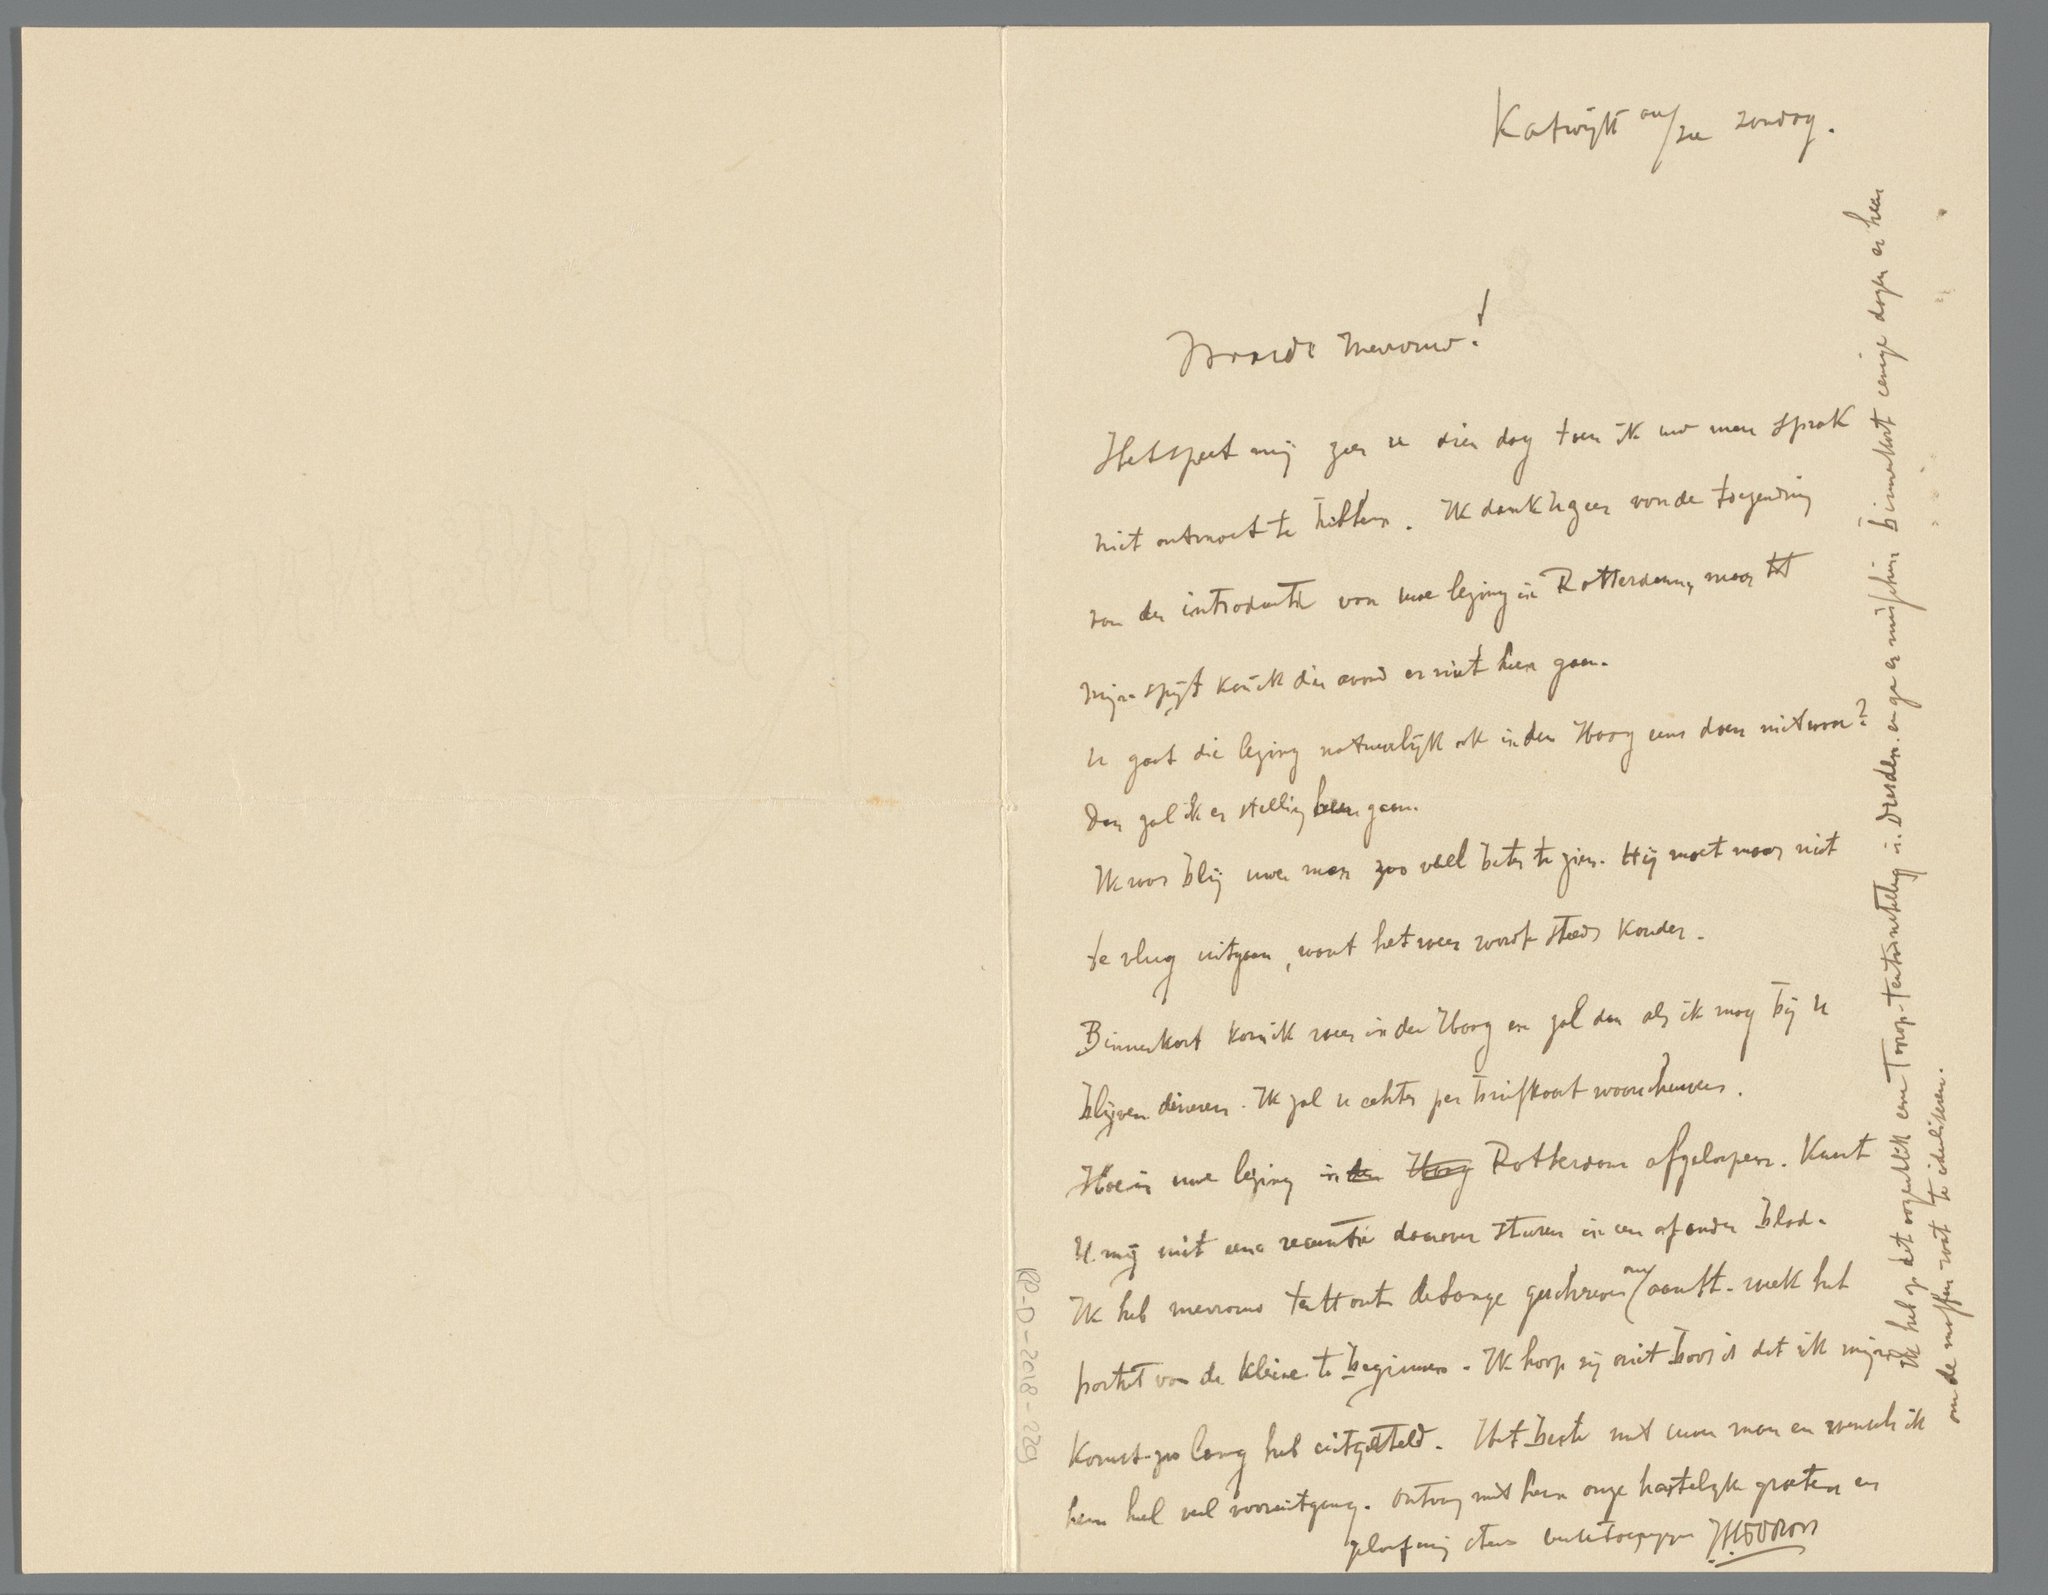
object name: letter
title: Brief aan Jeannette Bouman-Stuyling de Lange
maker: jan toorop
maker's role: draughtsman, painter, print maker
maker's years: 1858-1928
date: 1899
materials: ink, paper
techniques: pen, writing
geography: katwijk aan zee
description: Brief gericht aan Mevrouw Bouman Stuyling de Lange, van Stolkweg, Scheveningen.